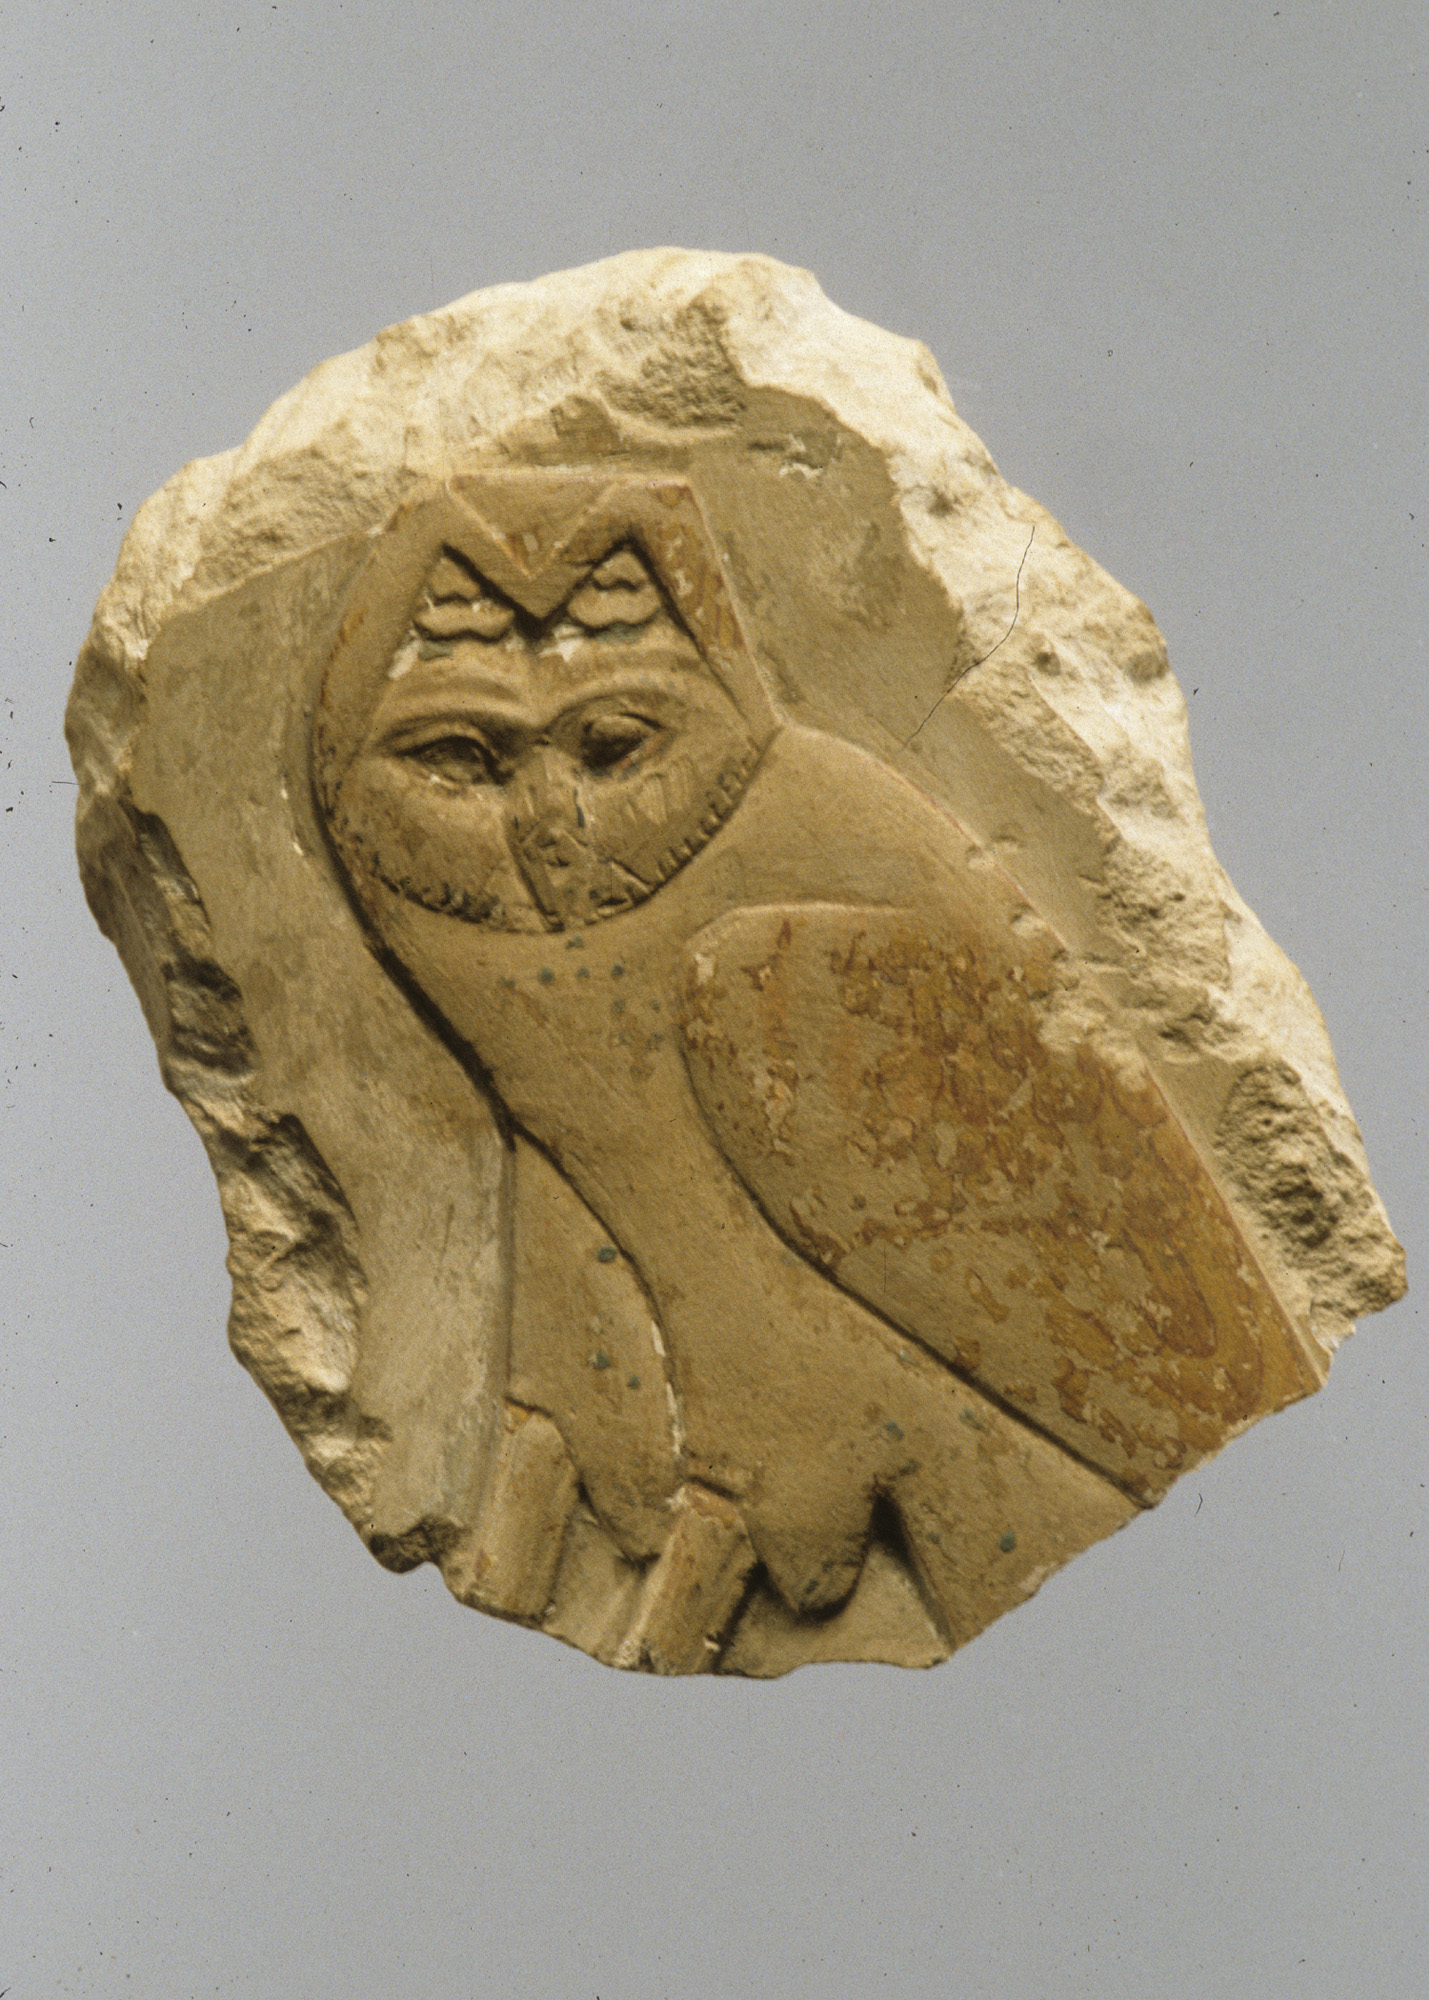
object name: relief, owl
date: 2030-1640 BCE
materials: limestone, pigment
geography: egypt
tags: owls